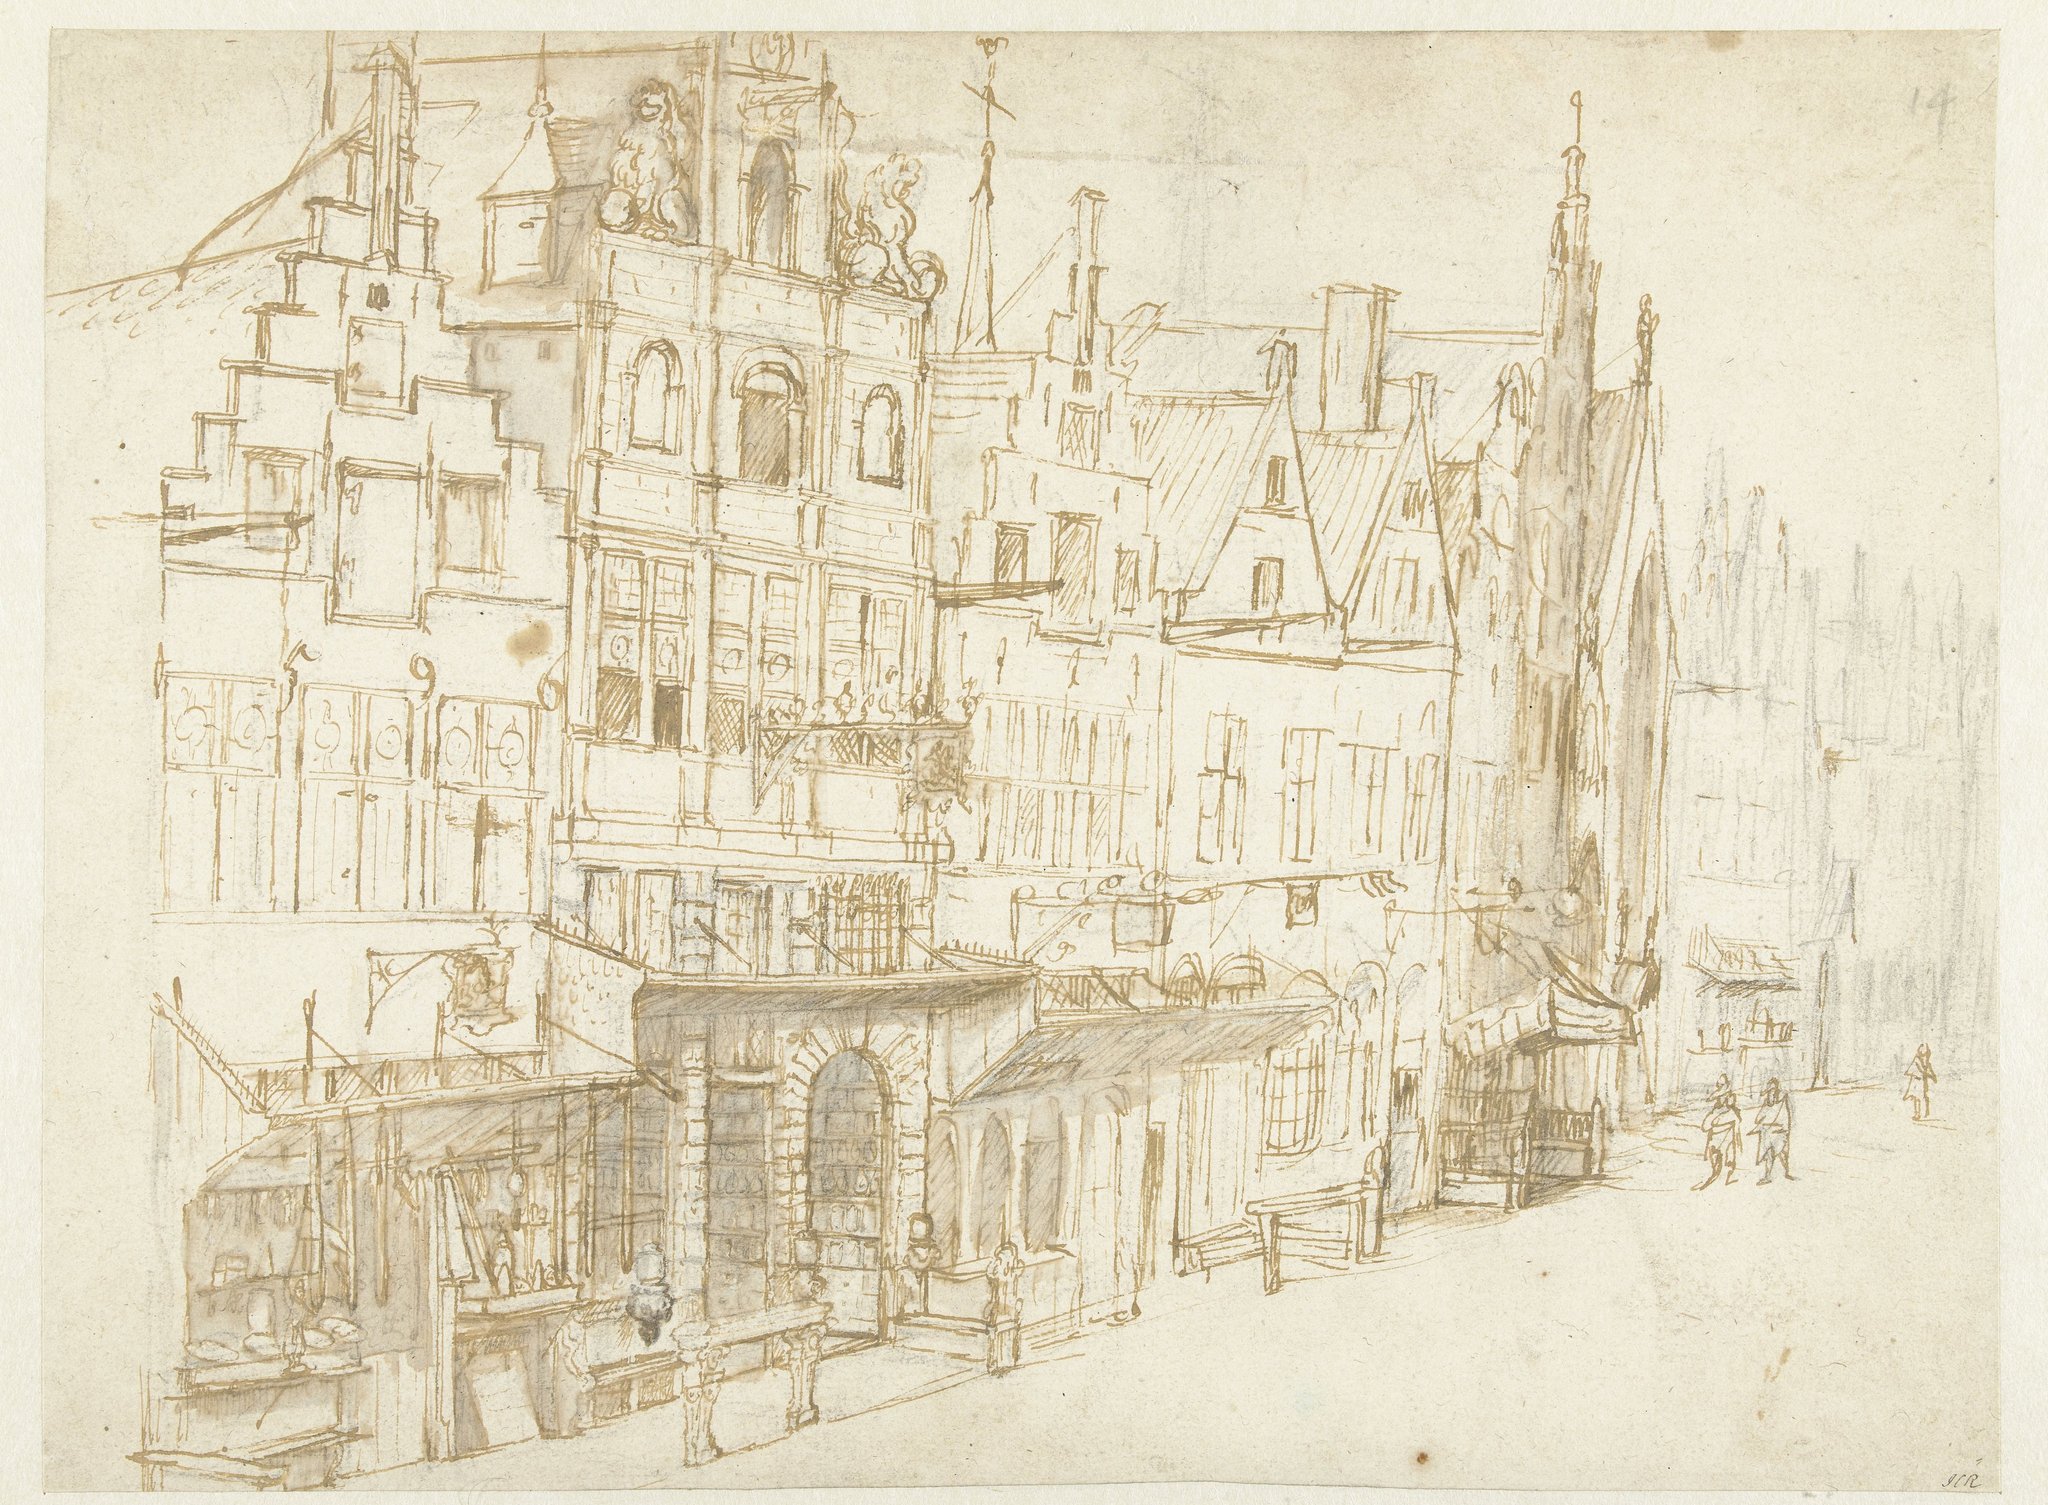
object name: drawing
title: Gezicht op een huizenrij in een stad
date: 1600-1699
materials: chalk, ink, paper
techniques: brush, pen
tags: urban housing, street